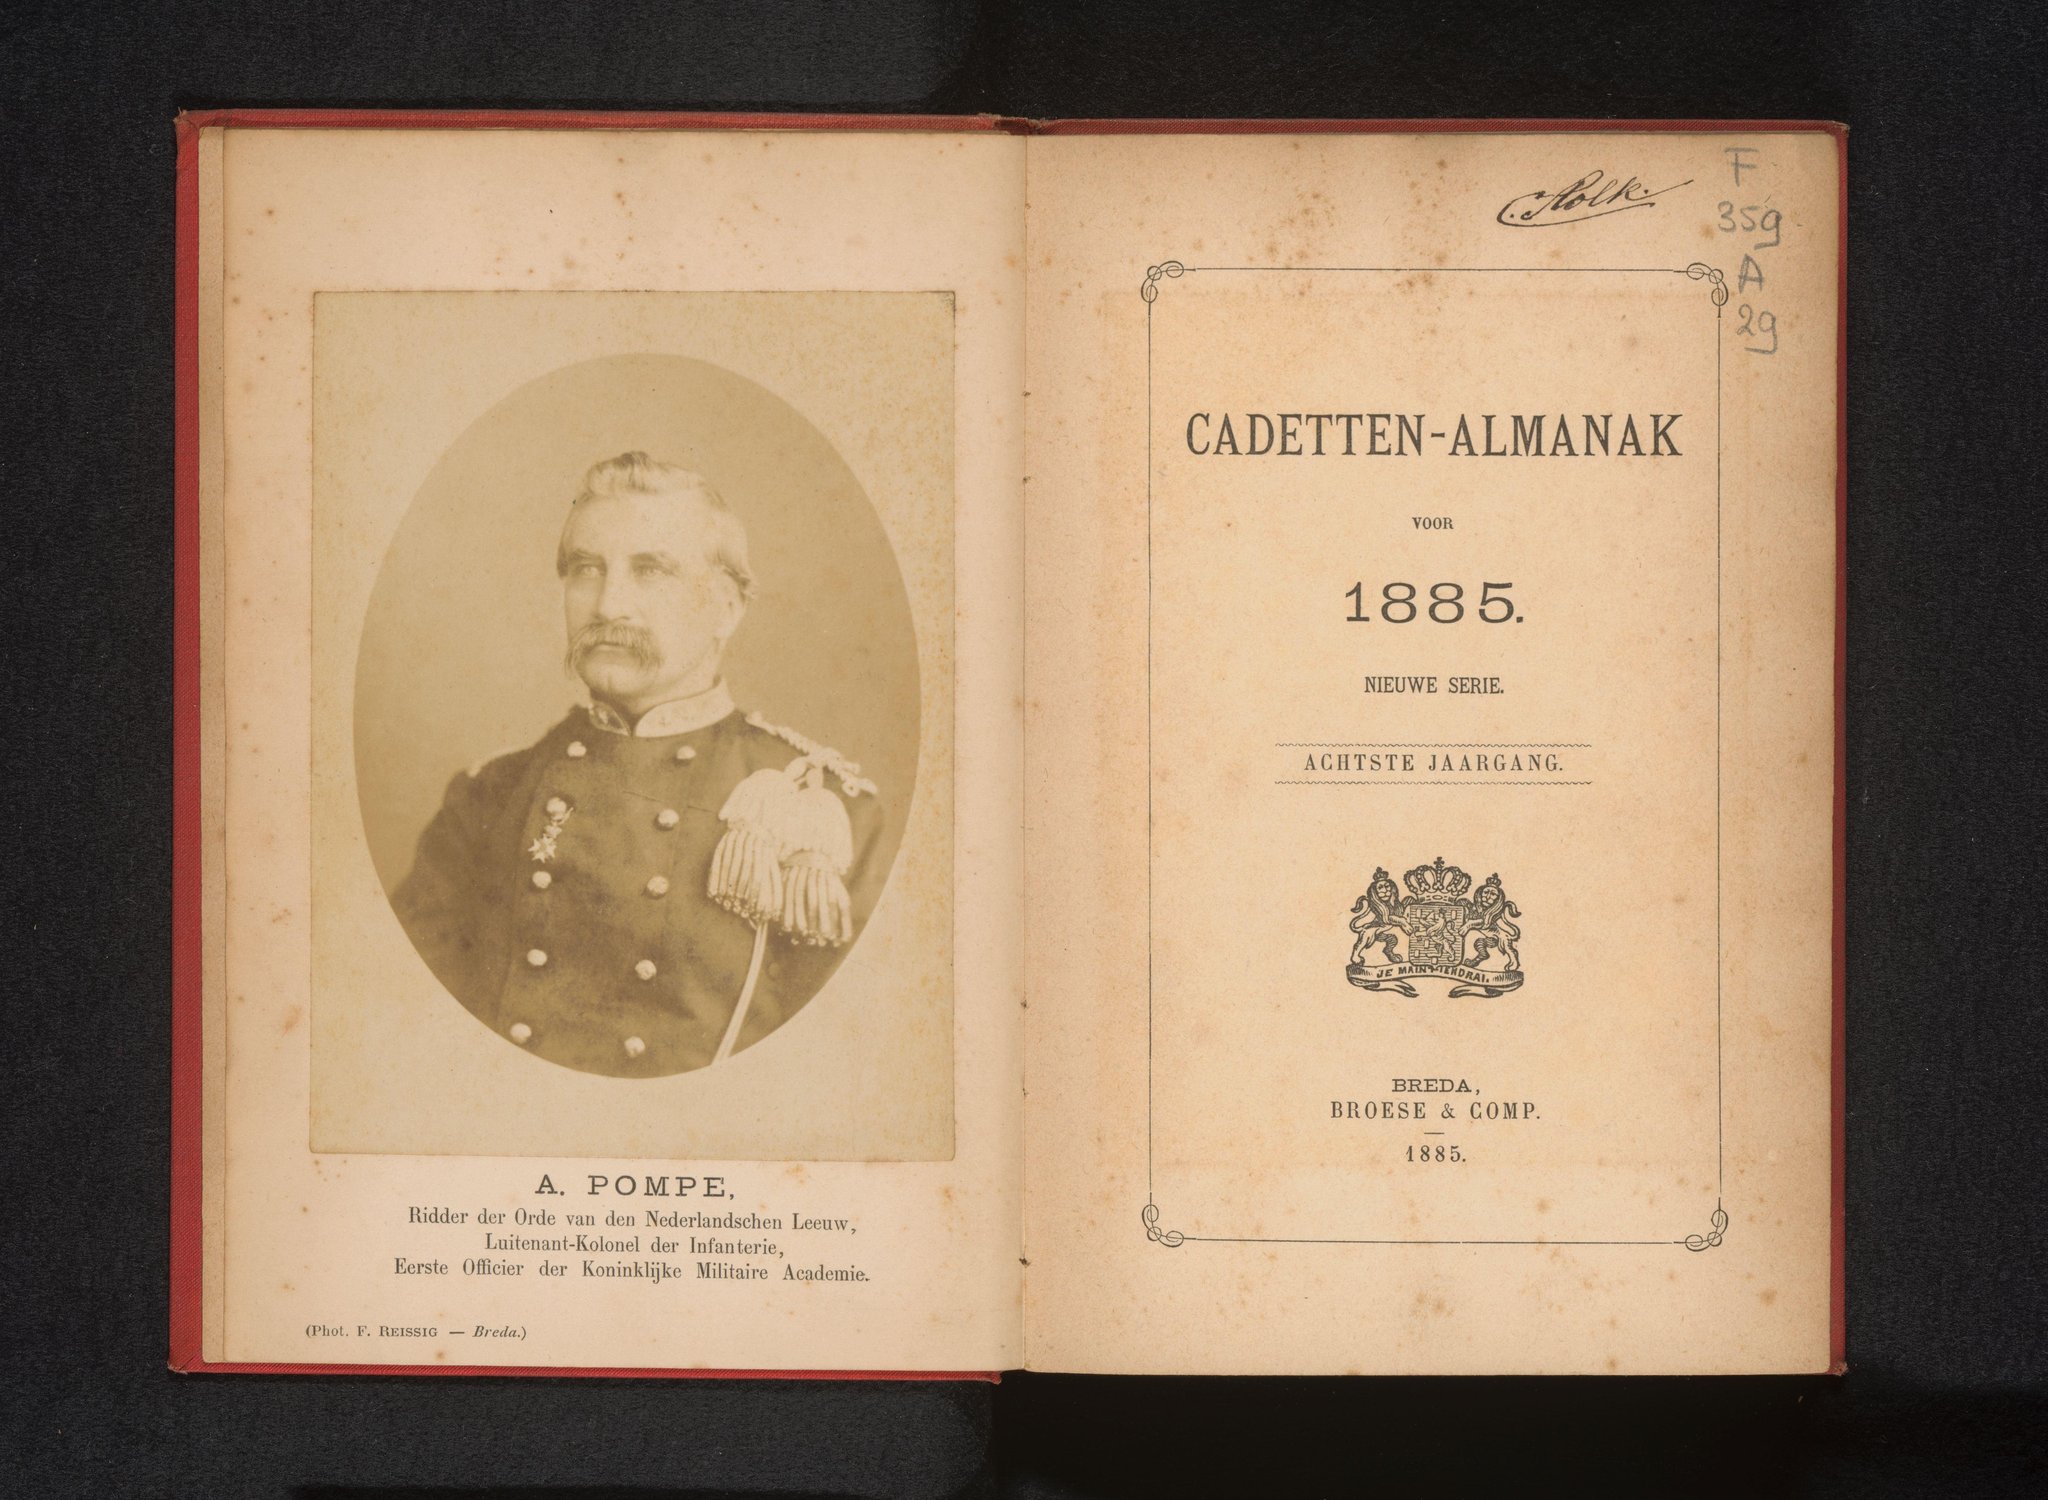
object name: photograph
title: A. Pompe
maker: franz reissig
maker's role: fotograaf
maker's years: 1852-1936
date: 1880-1885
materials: photographic support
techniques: albumen print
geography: breda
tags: the hague, historical persons, officer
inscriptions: inscription: ‘Ridder der Orde van den Nederlandschen Leeuw,/ Luitenant-Kolonel der Infanterie,/ Eerste Officier der Koninklijke Militaire Academie.’